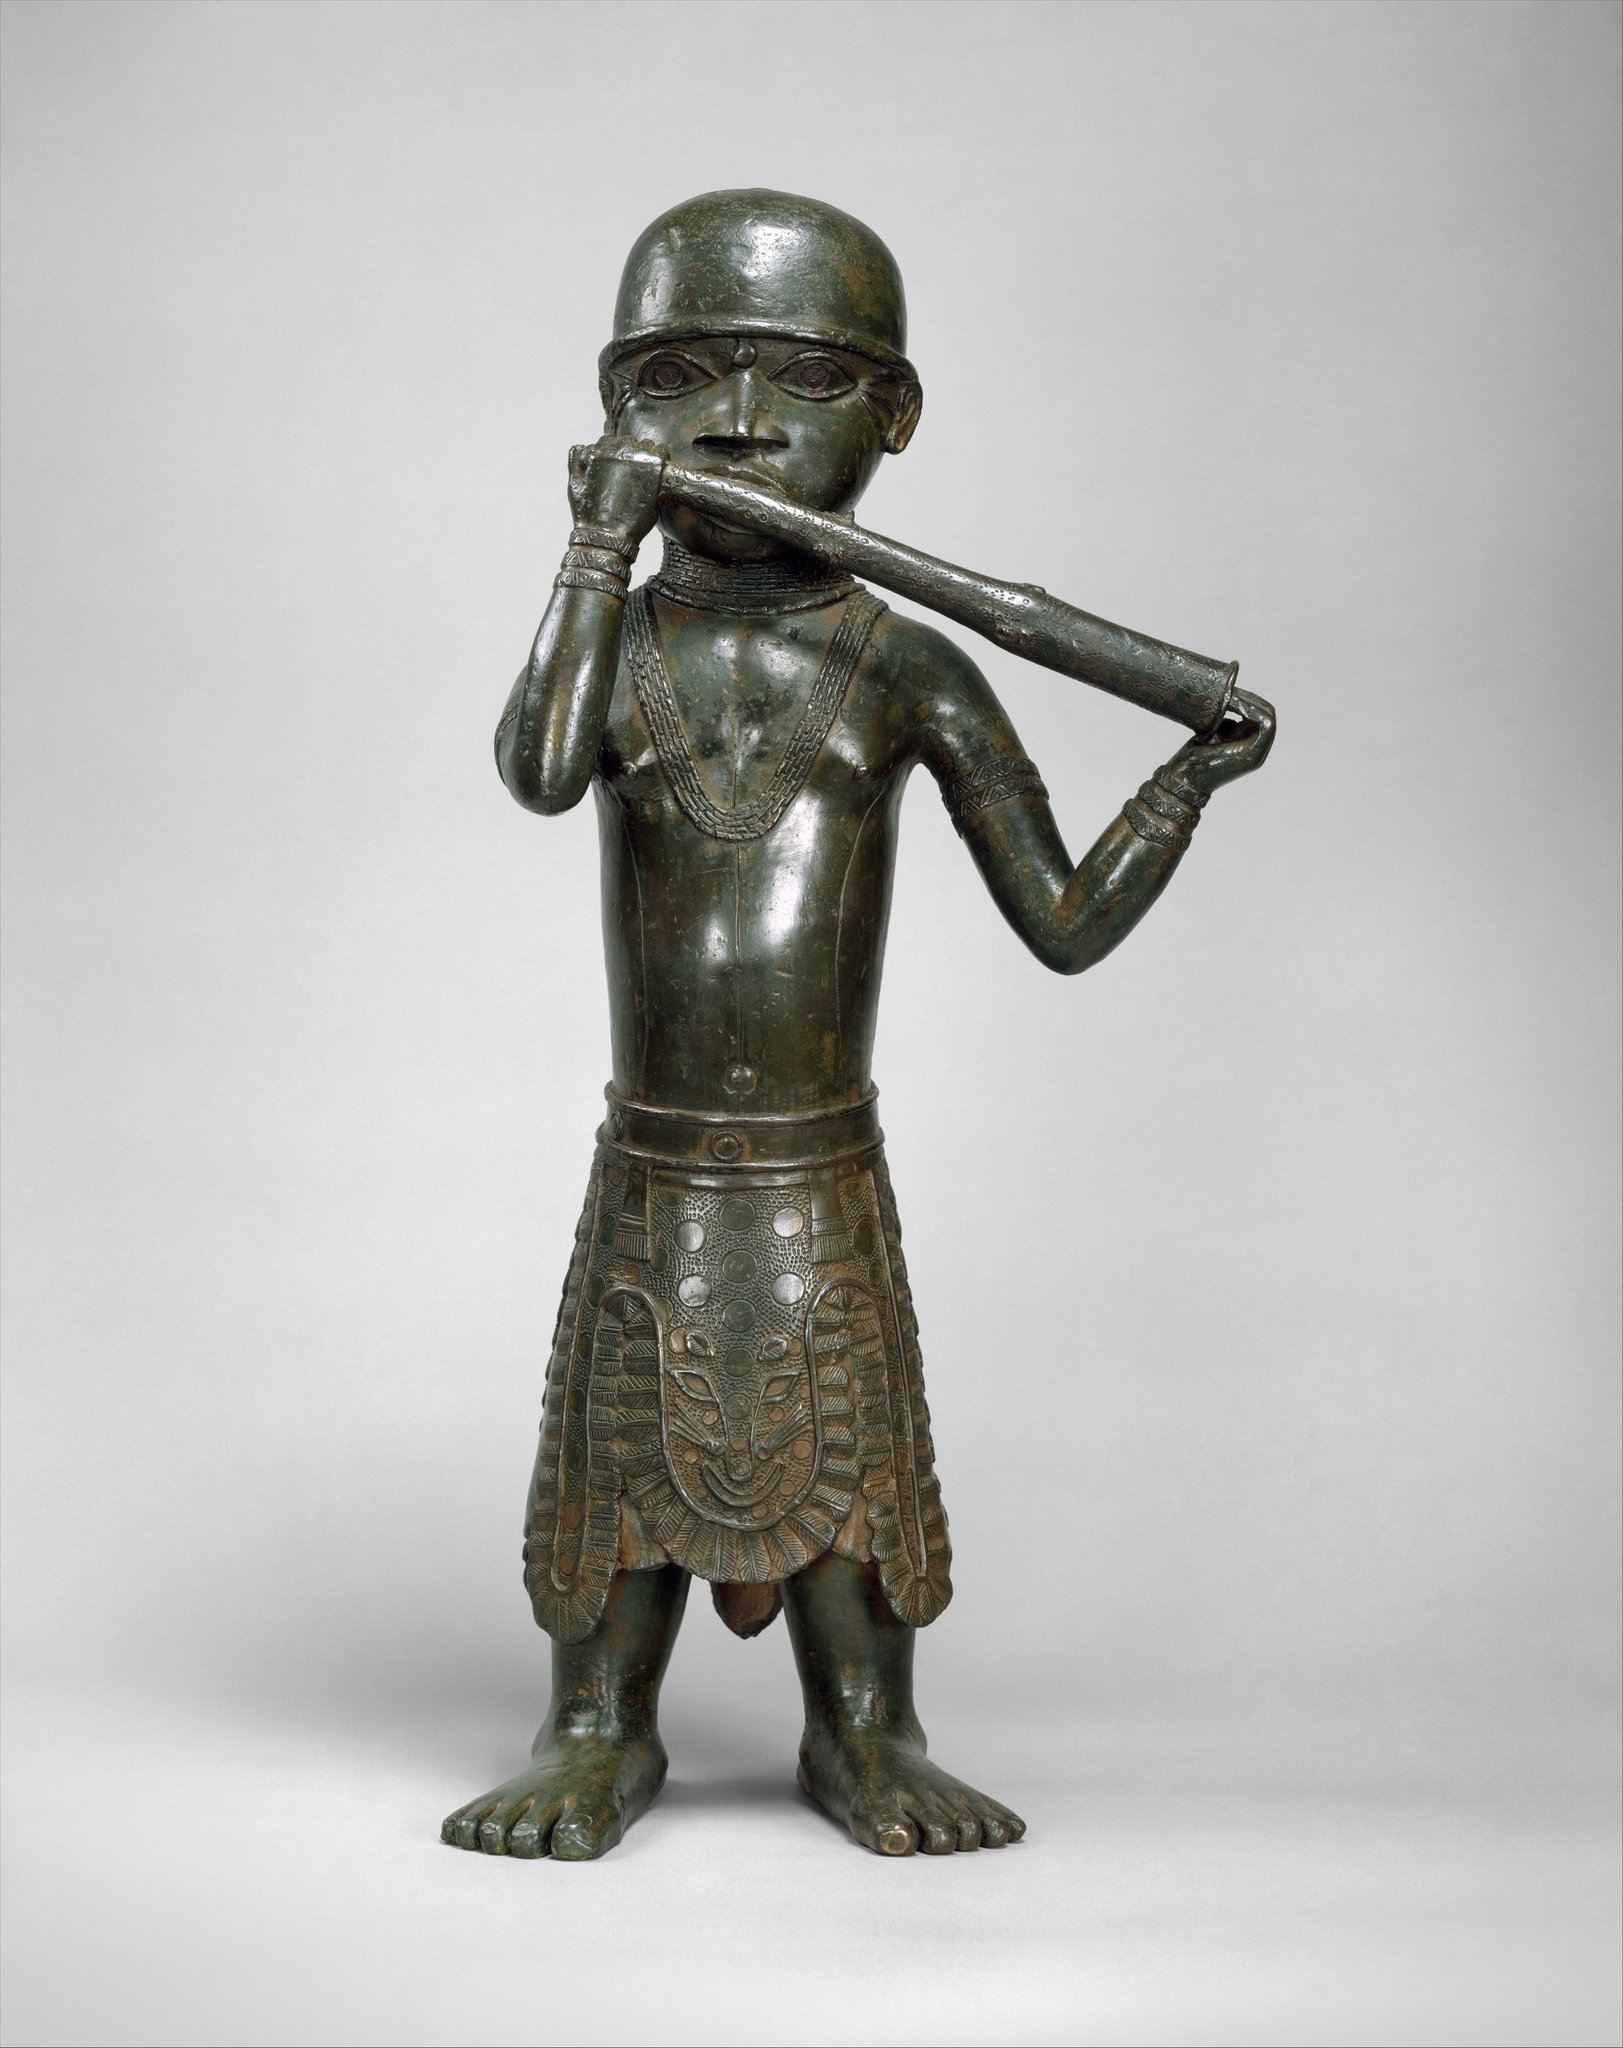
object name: figure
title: Horn Player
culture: edo period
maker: ìgùn ẹ́rọ̀nwwọ̀n (brass-casting guild) artists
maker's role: artist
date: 1550-1680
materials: brass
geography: nigeria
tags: men,musicians